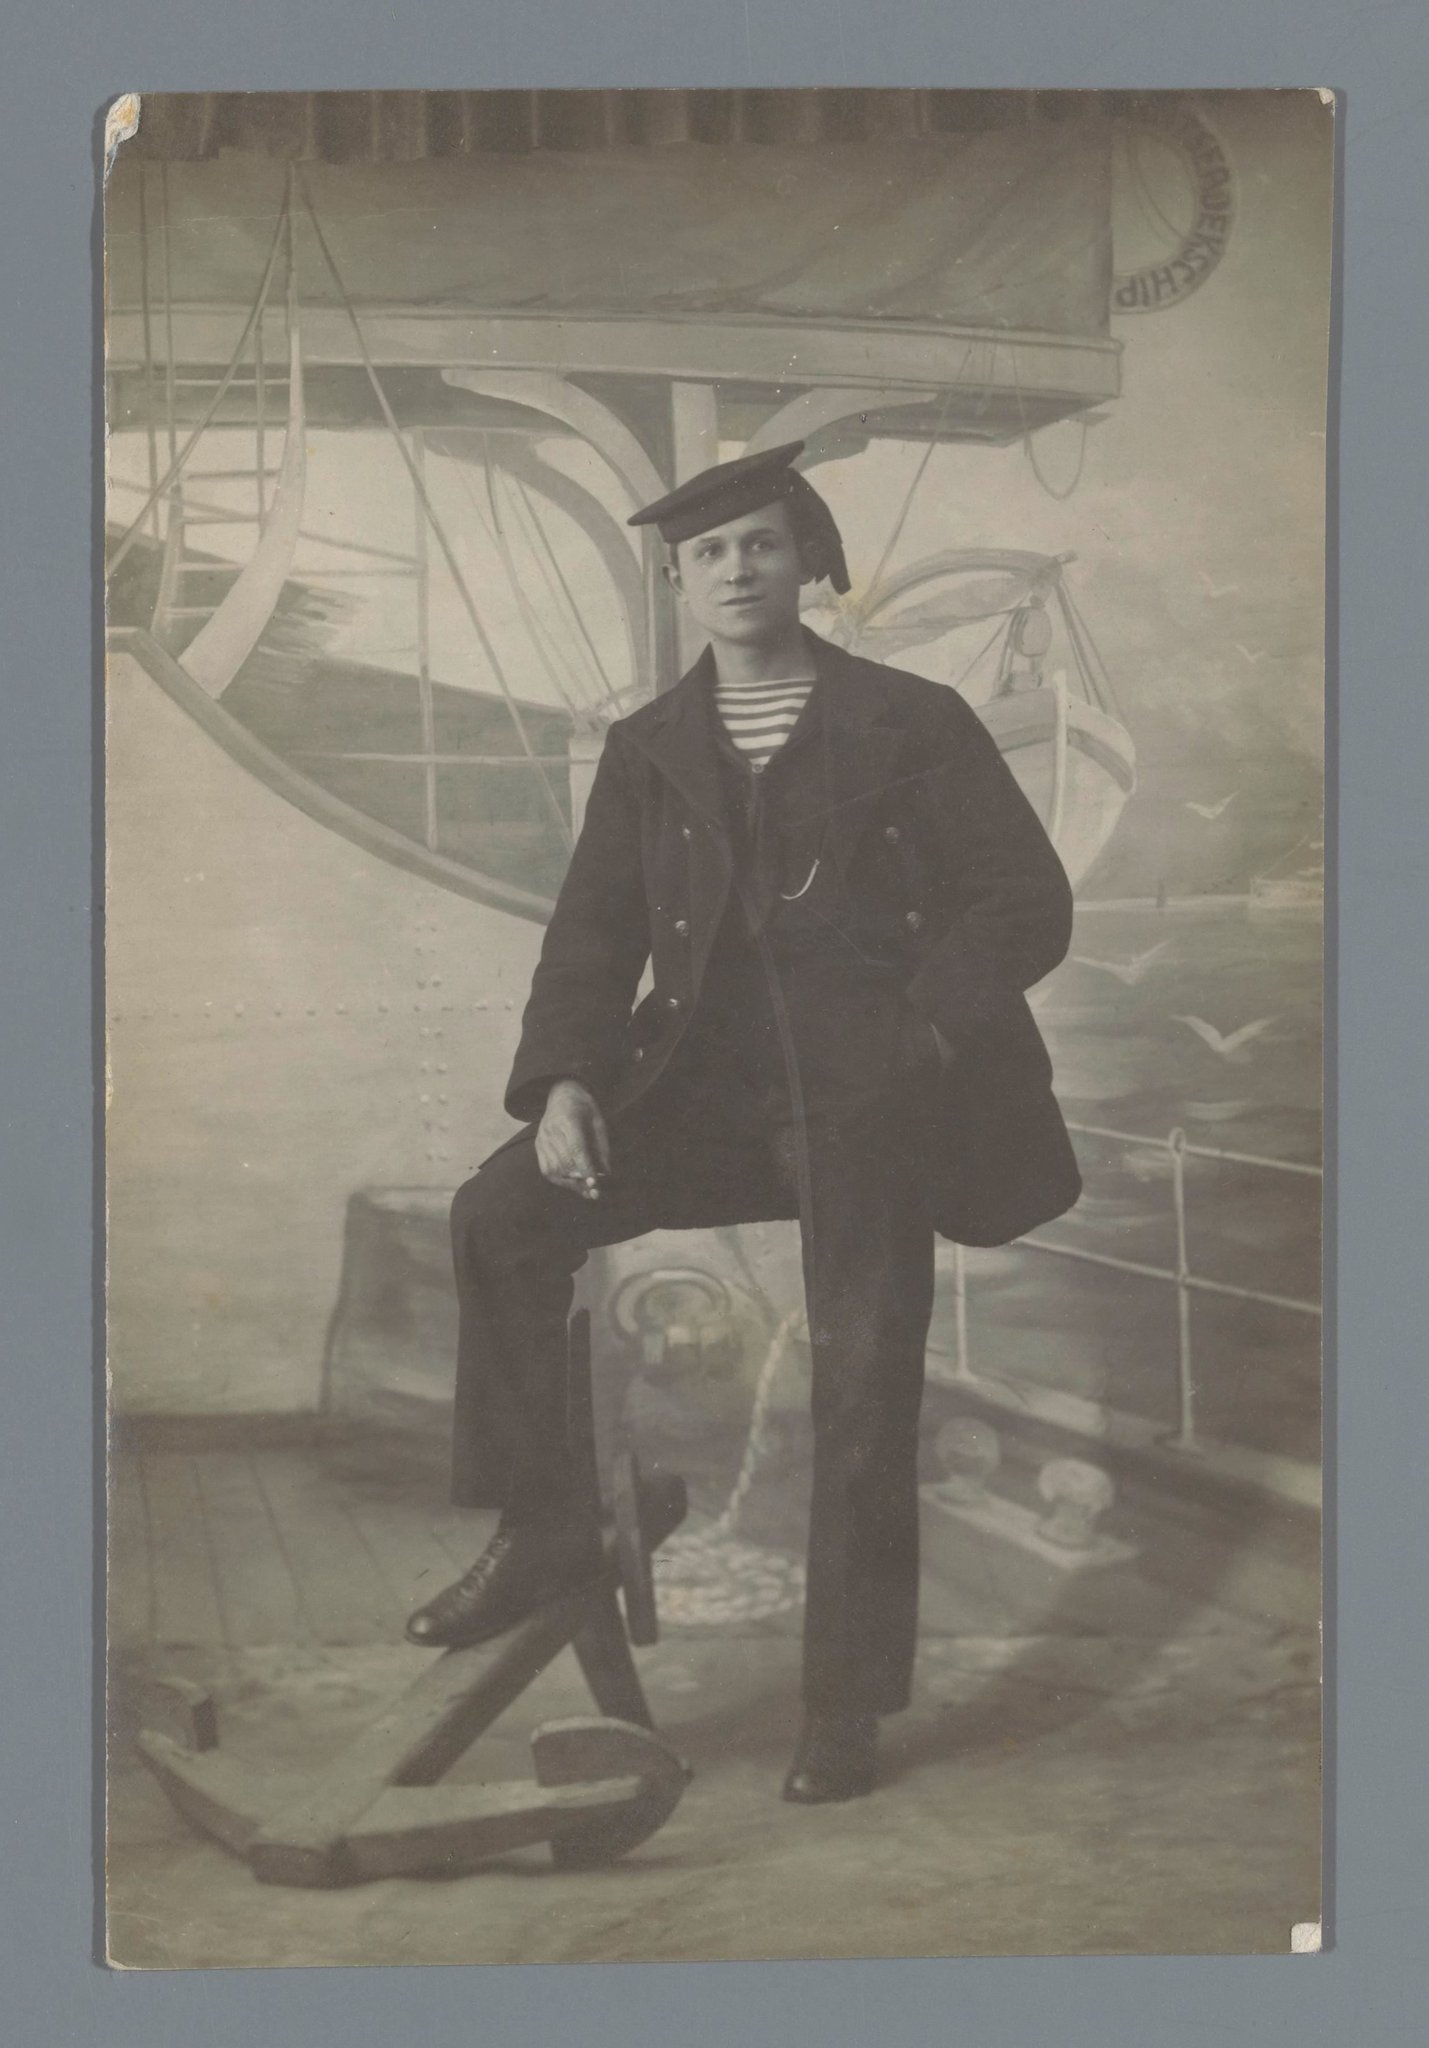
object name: photograph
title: Studioportret van een onbekende man in matrozenuniform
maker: jozeph kreuger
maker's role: fotograaf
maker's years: 1886-1971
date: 1915-1925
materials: photographic support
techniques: gelatin silver print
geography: den helder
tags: studio ~ photographer, seaman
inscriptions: inscription: ‘Chef Kreuger Koningstraat 88 Fotograaf, Den Helder’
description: Dezelfde man is afgebeeld op RP-F-F20729.